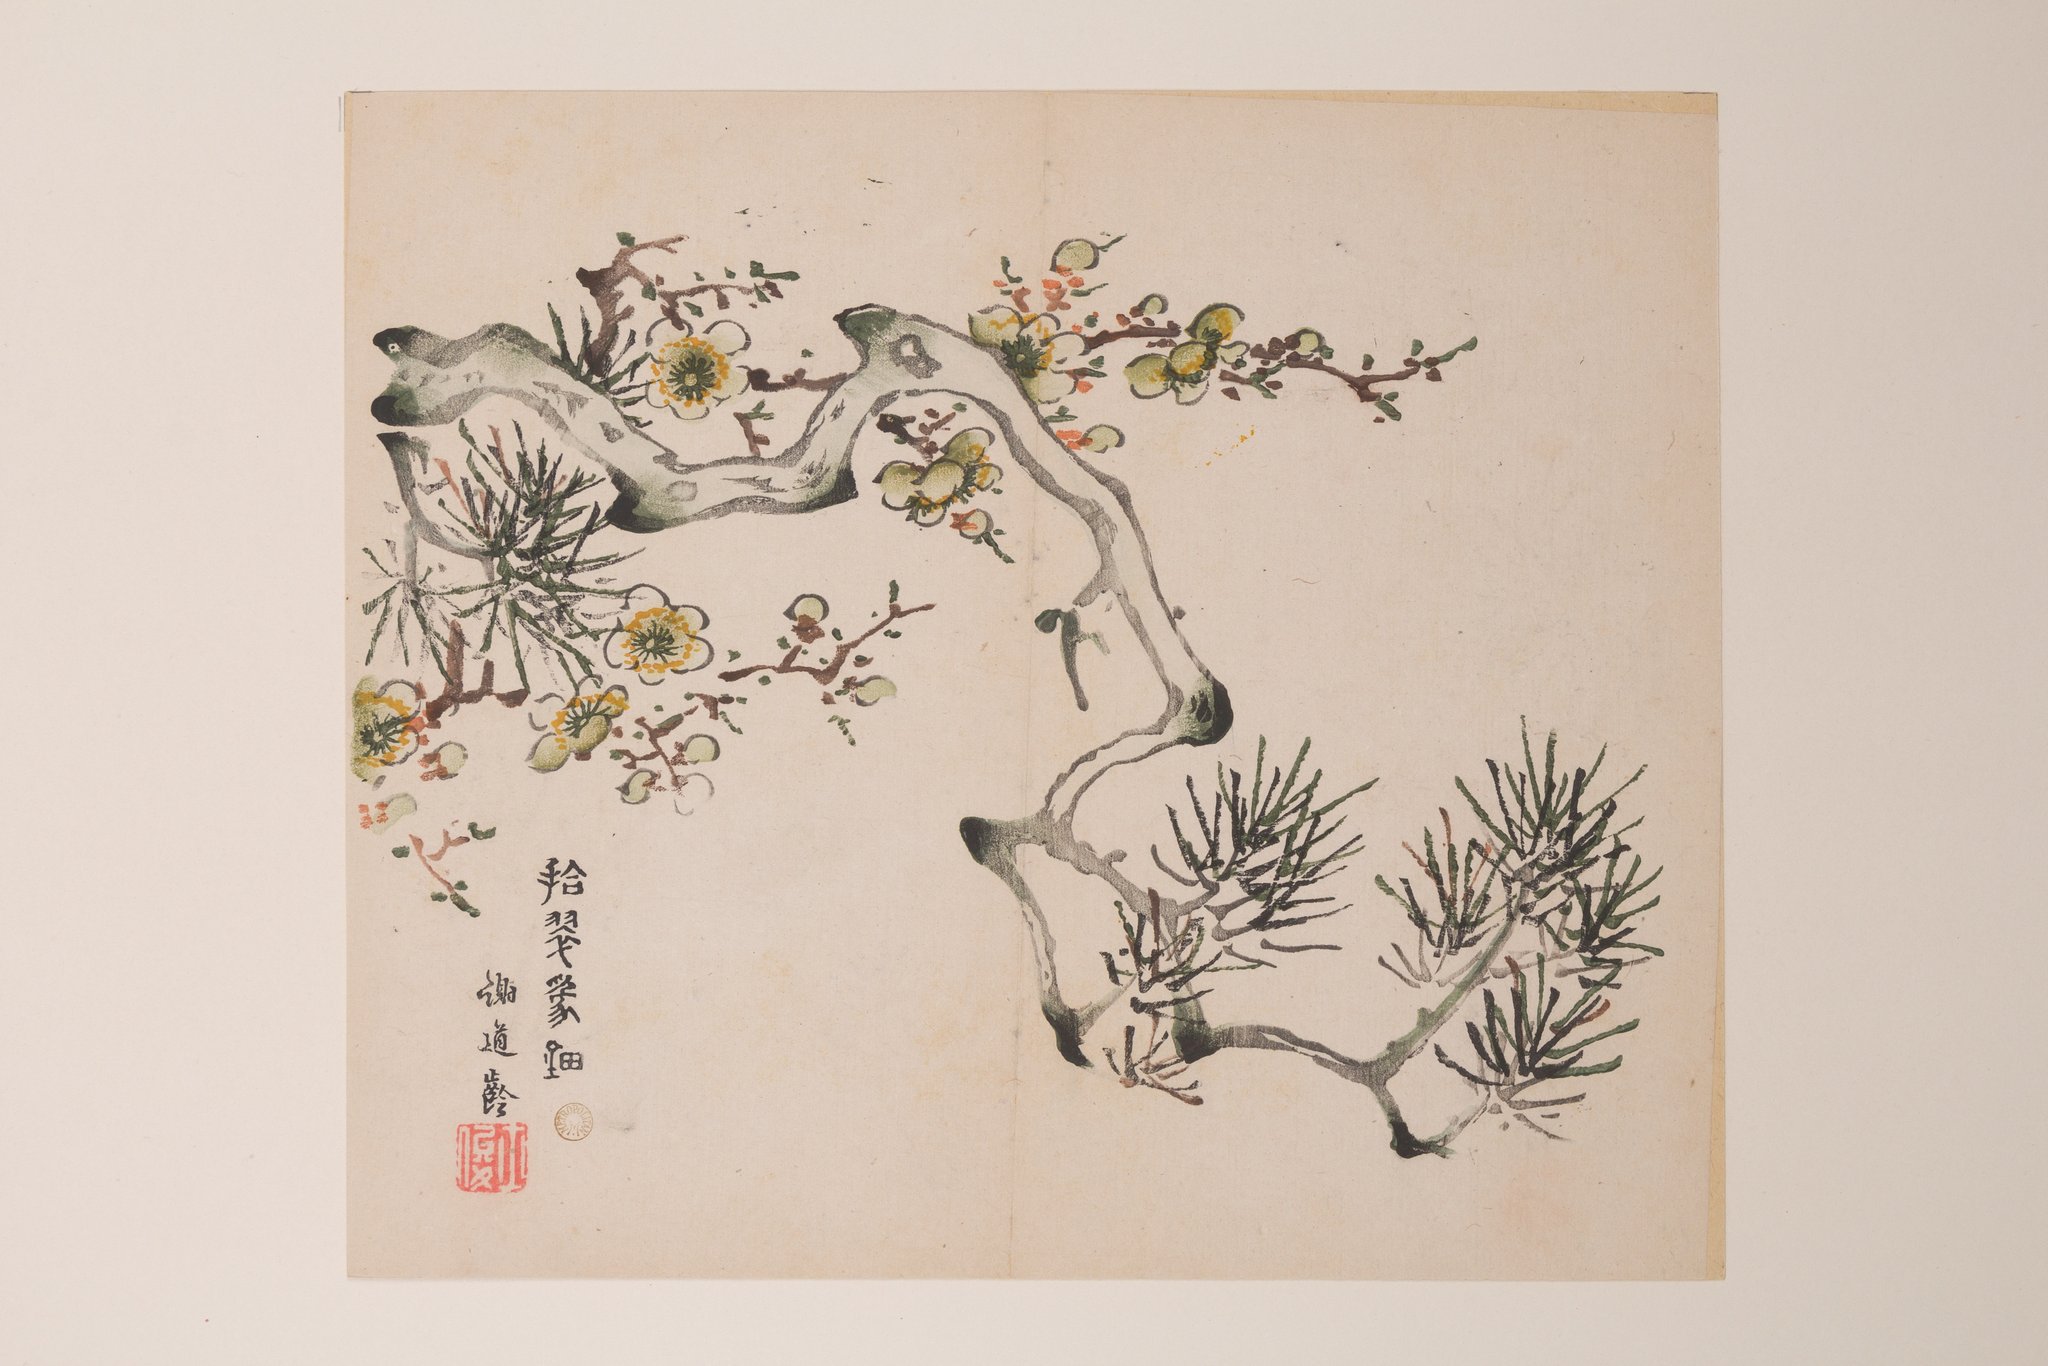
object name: print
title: Page from the Ten Bamboo Studio Manual of Painting and Calligraphy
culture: chinese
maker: hu zhengyan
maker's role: artist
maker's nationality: chinese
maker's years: 1584-1634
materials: ink, paper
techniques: printing